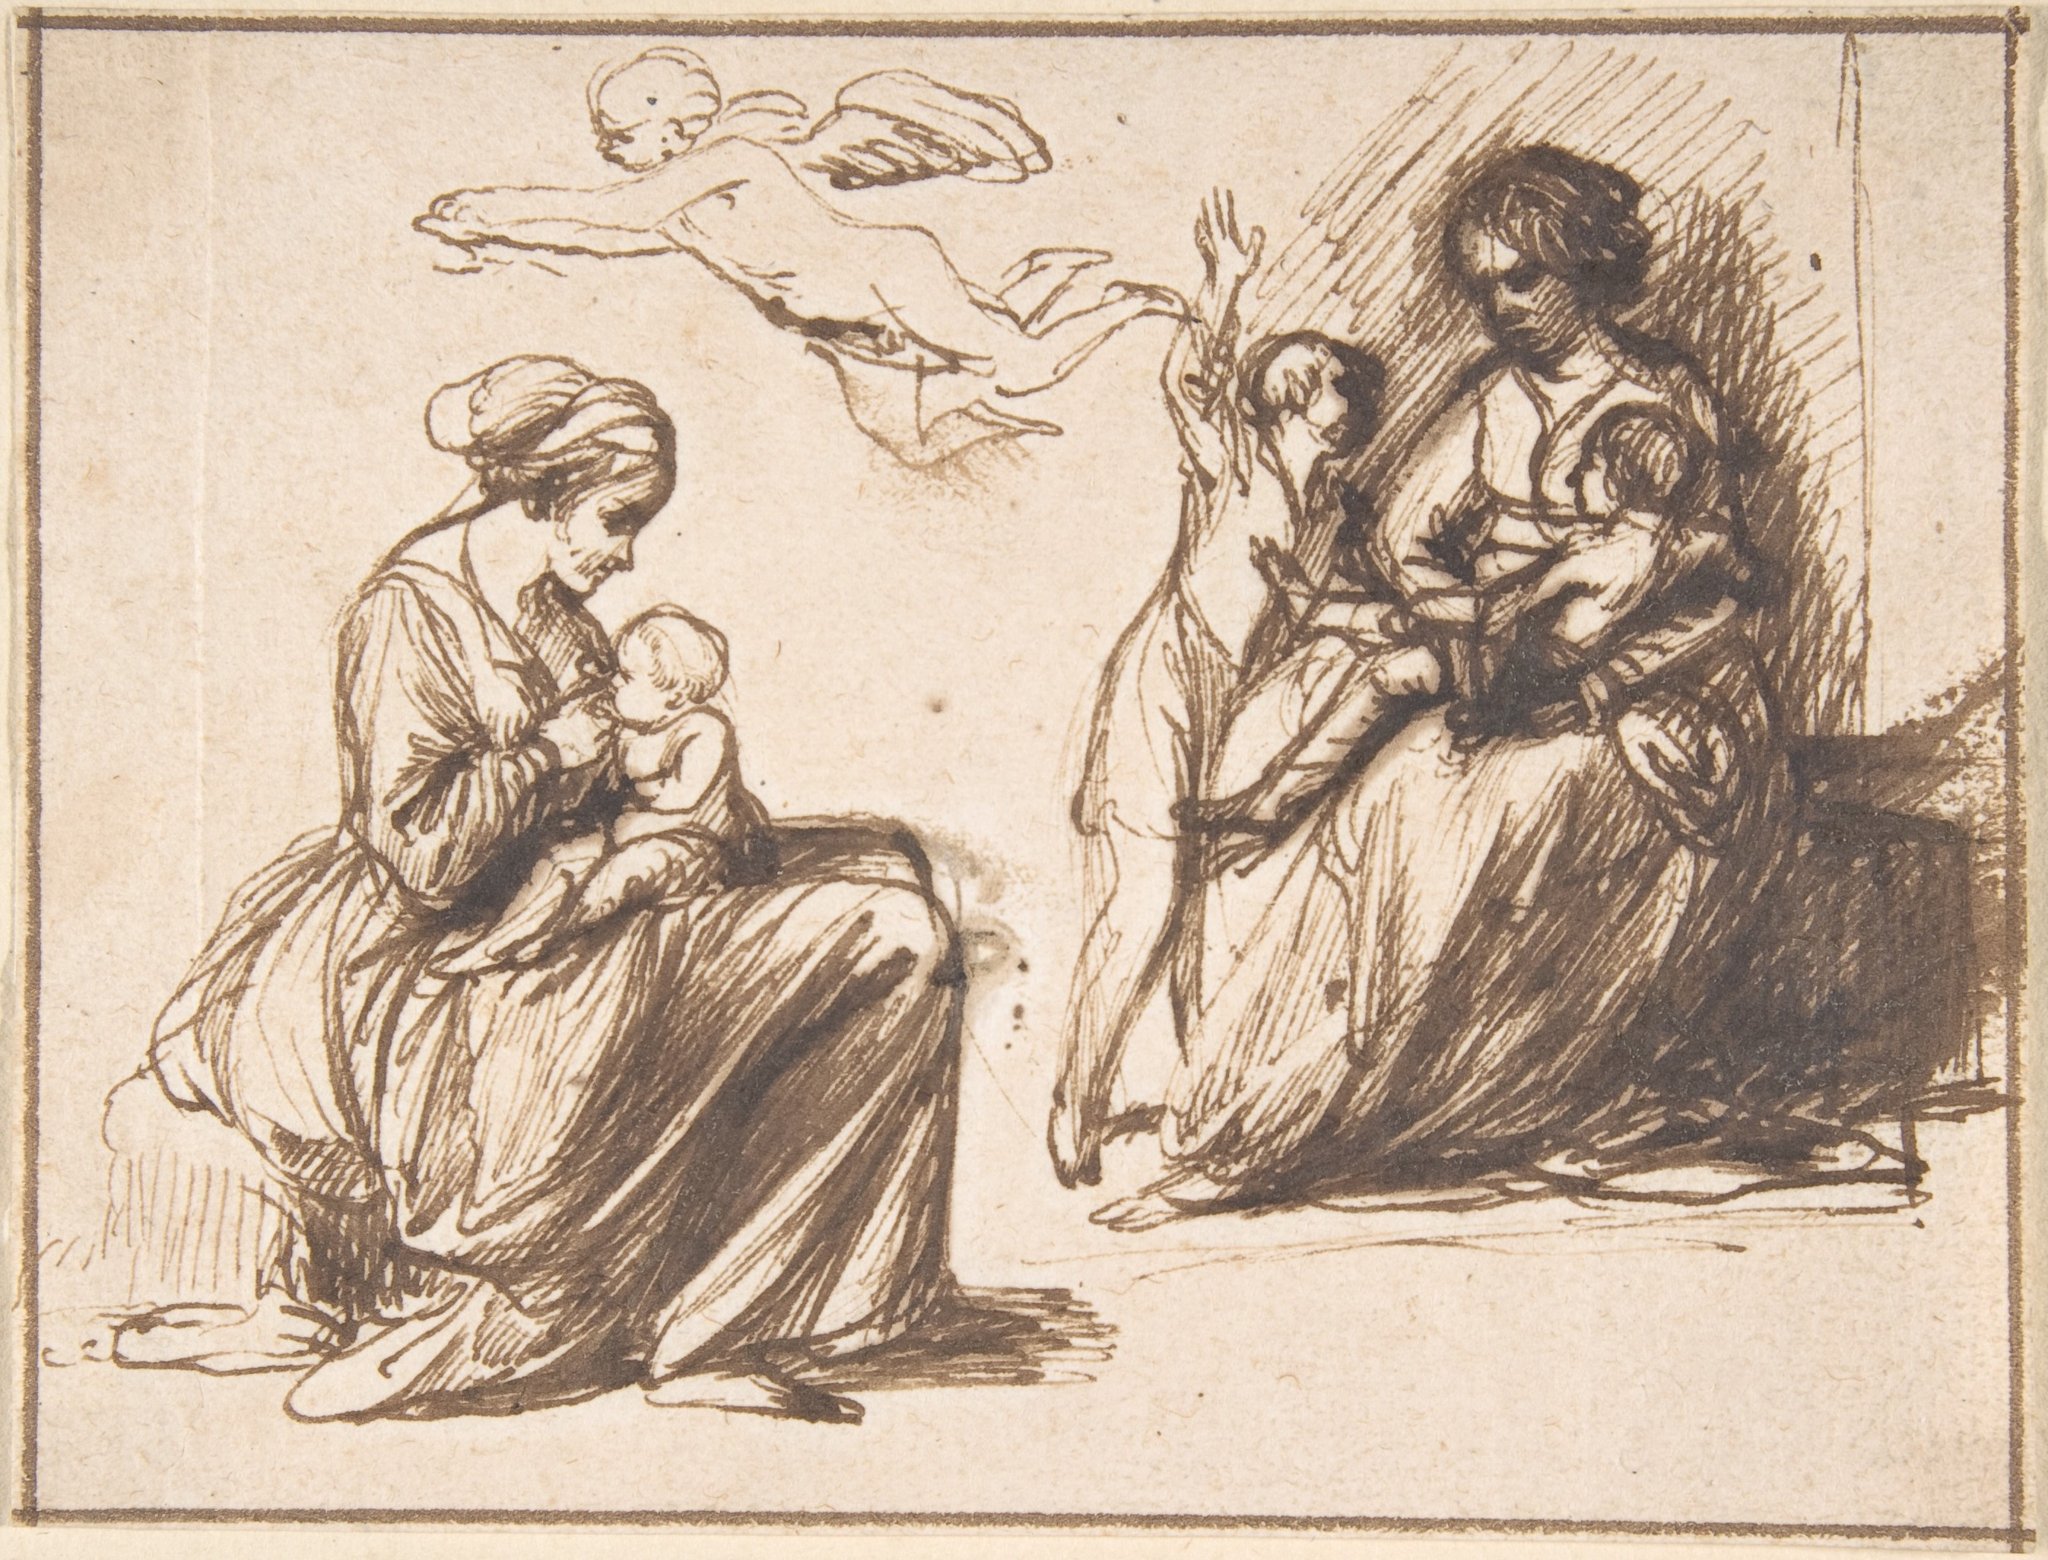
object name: drawing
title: Study Sheet with Two Seated Children and an Angel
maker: hendrick goudt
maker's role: artist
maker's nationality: dutch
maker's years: 1580-1648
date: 1601-1633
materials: ink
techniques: pen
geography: netherlands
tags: children,infants,women,angels